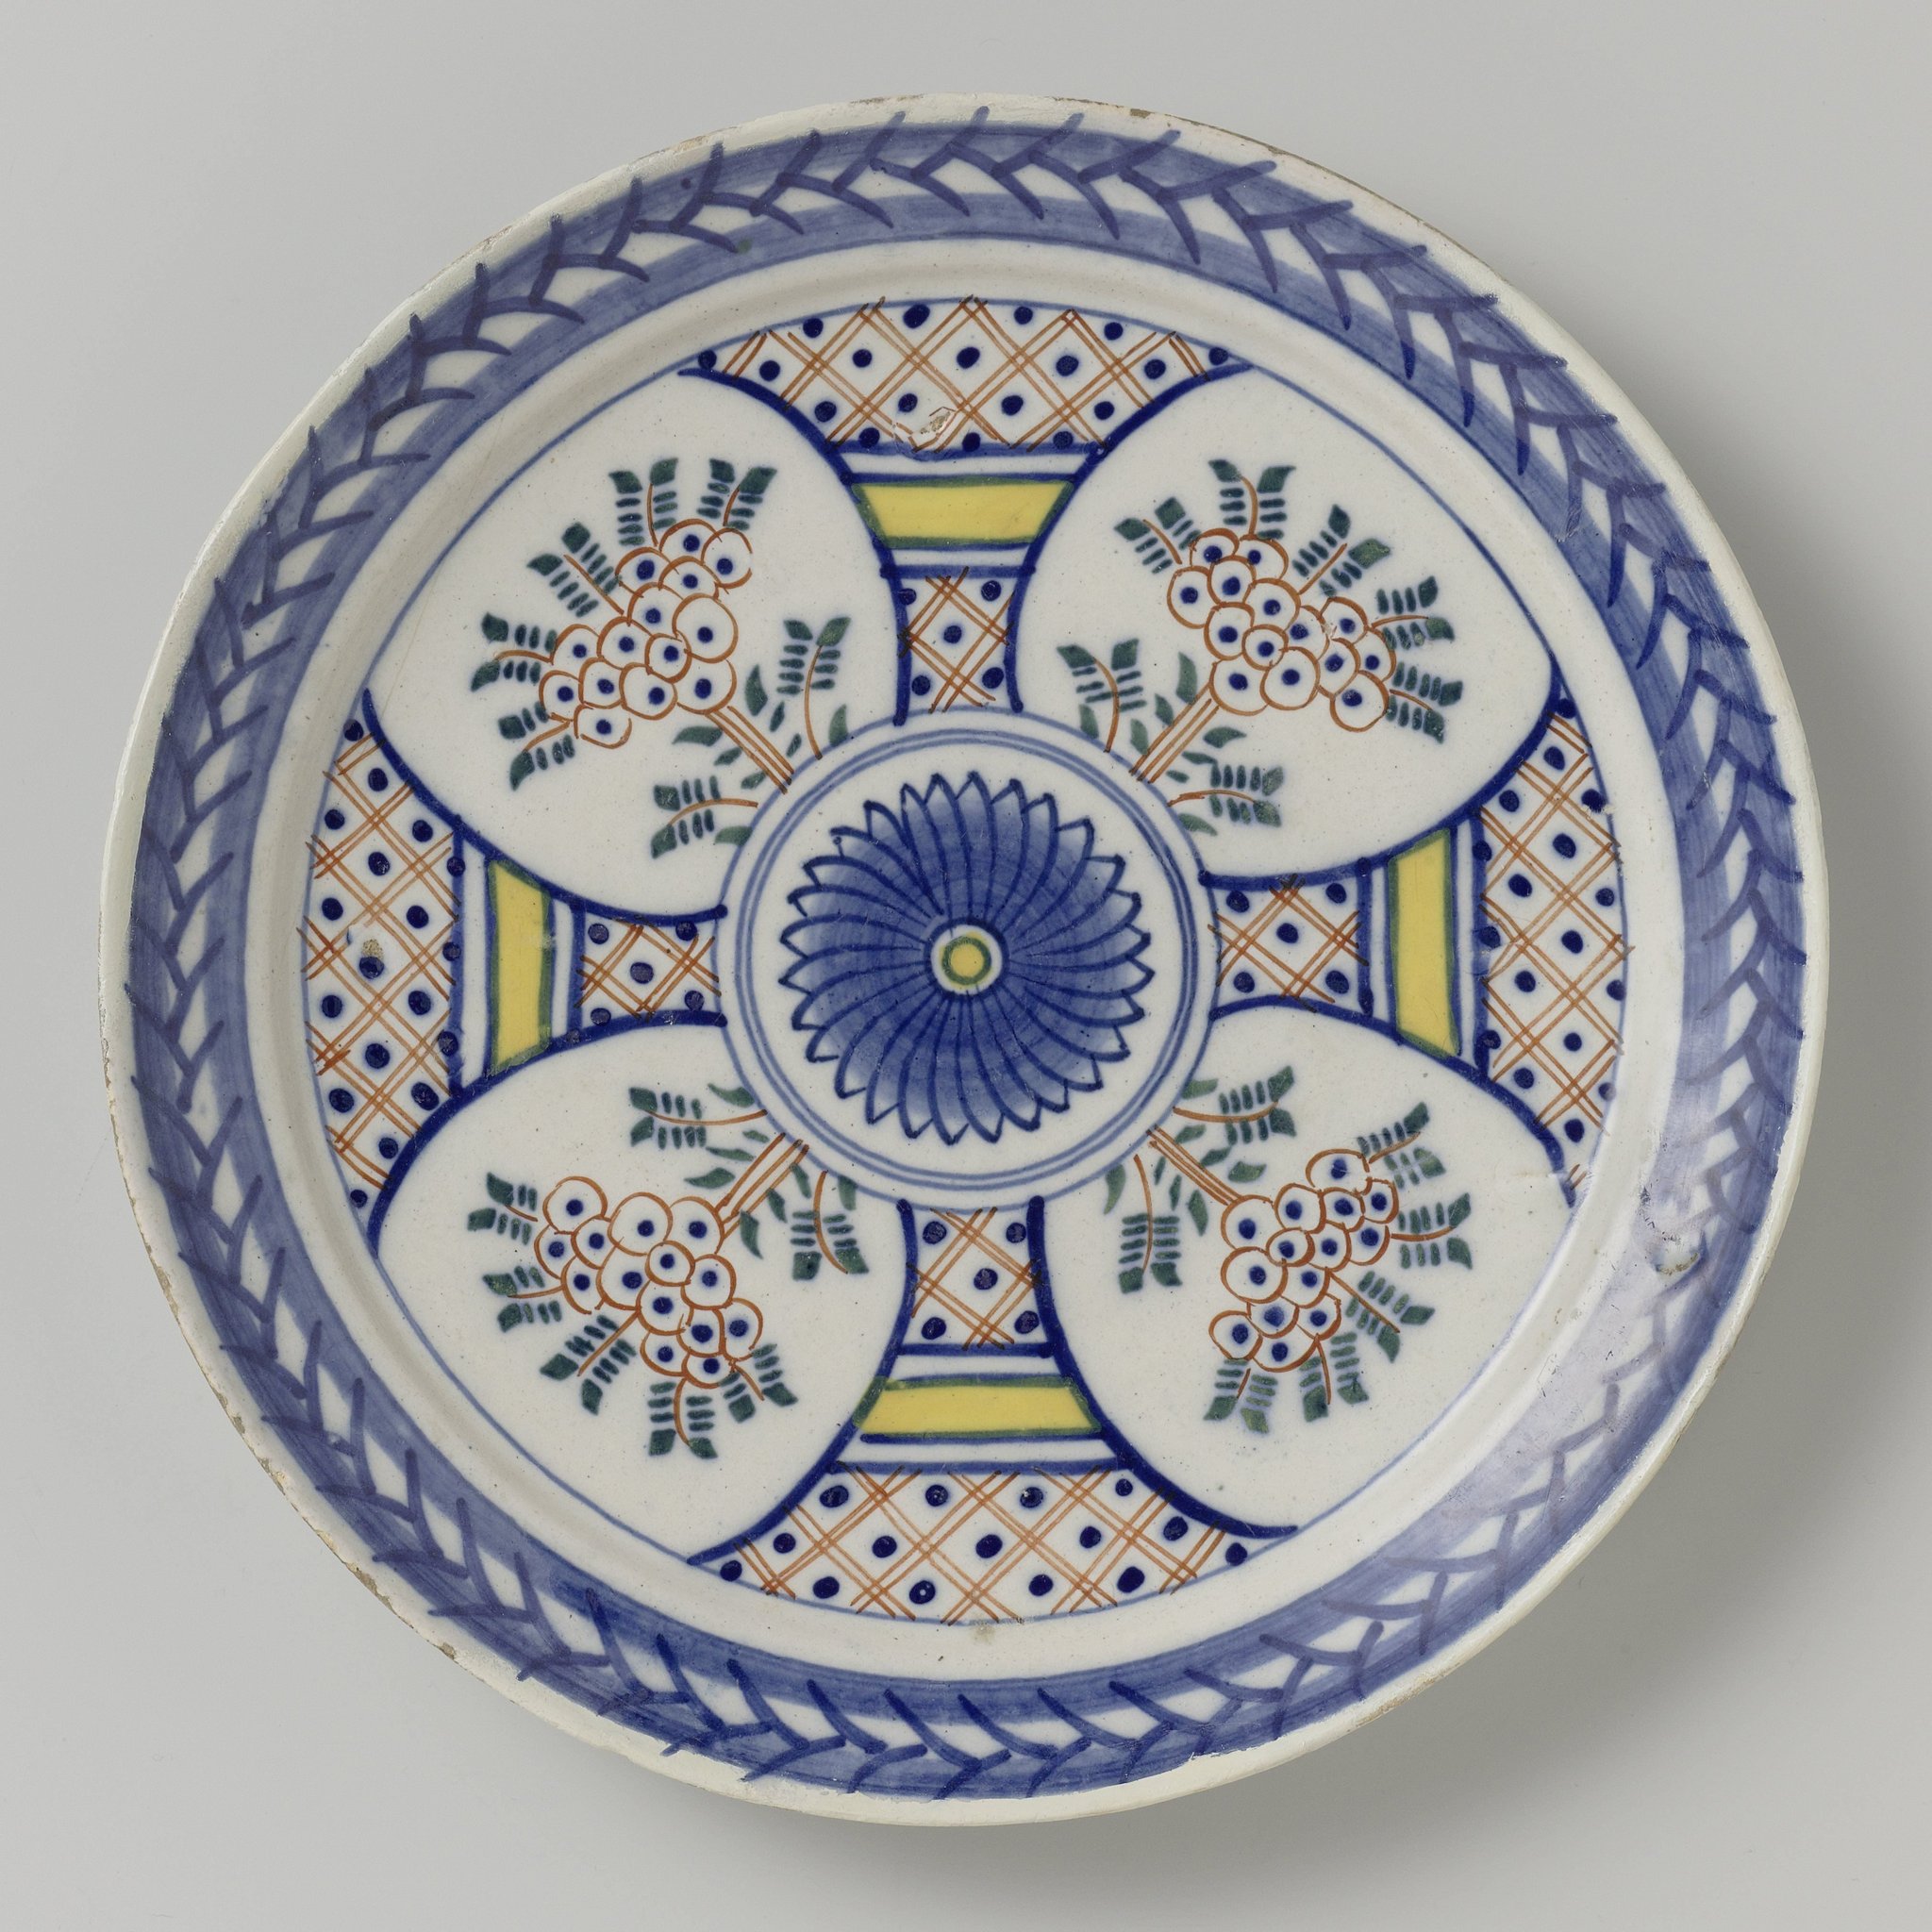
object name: plate dish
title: bord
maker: Anonymous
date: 1725-1770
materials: earthenware, glaze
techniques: painted, polychromy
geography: delft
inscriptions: mark: ‘onbekend merk bestaande uit drie strepen (figuratief teken pi)’, collector's mark: ‘koninklijk oudheidkundig genootschap no. 44’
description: Rond bord van veelkleurig beschilderde faience, met op het plat een cirkel waarbinnen een blauwe ster en een blauwe rand. Daar omheen zijn vier veelkleurige waaiervormige vakken met bloemen geschilderd. Op de achterzijde staat een merk.